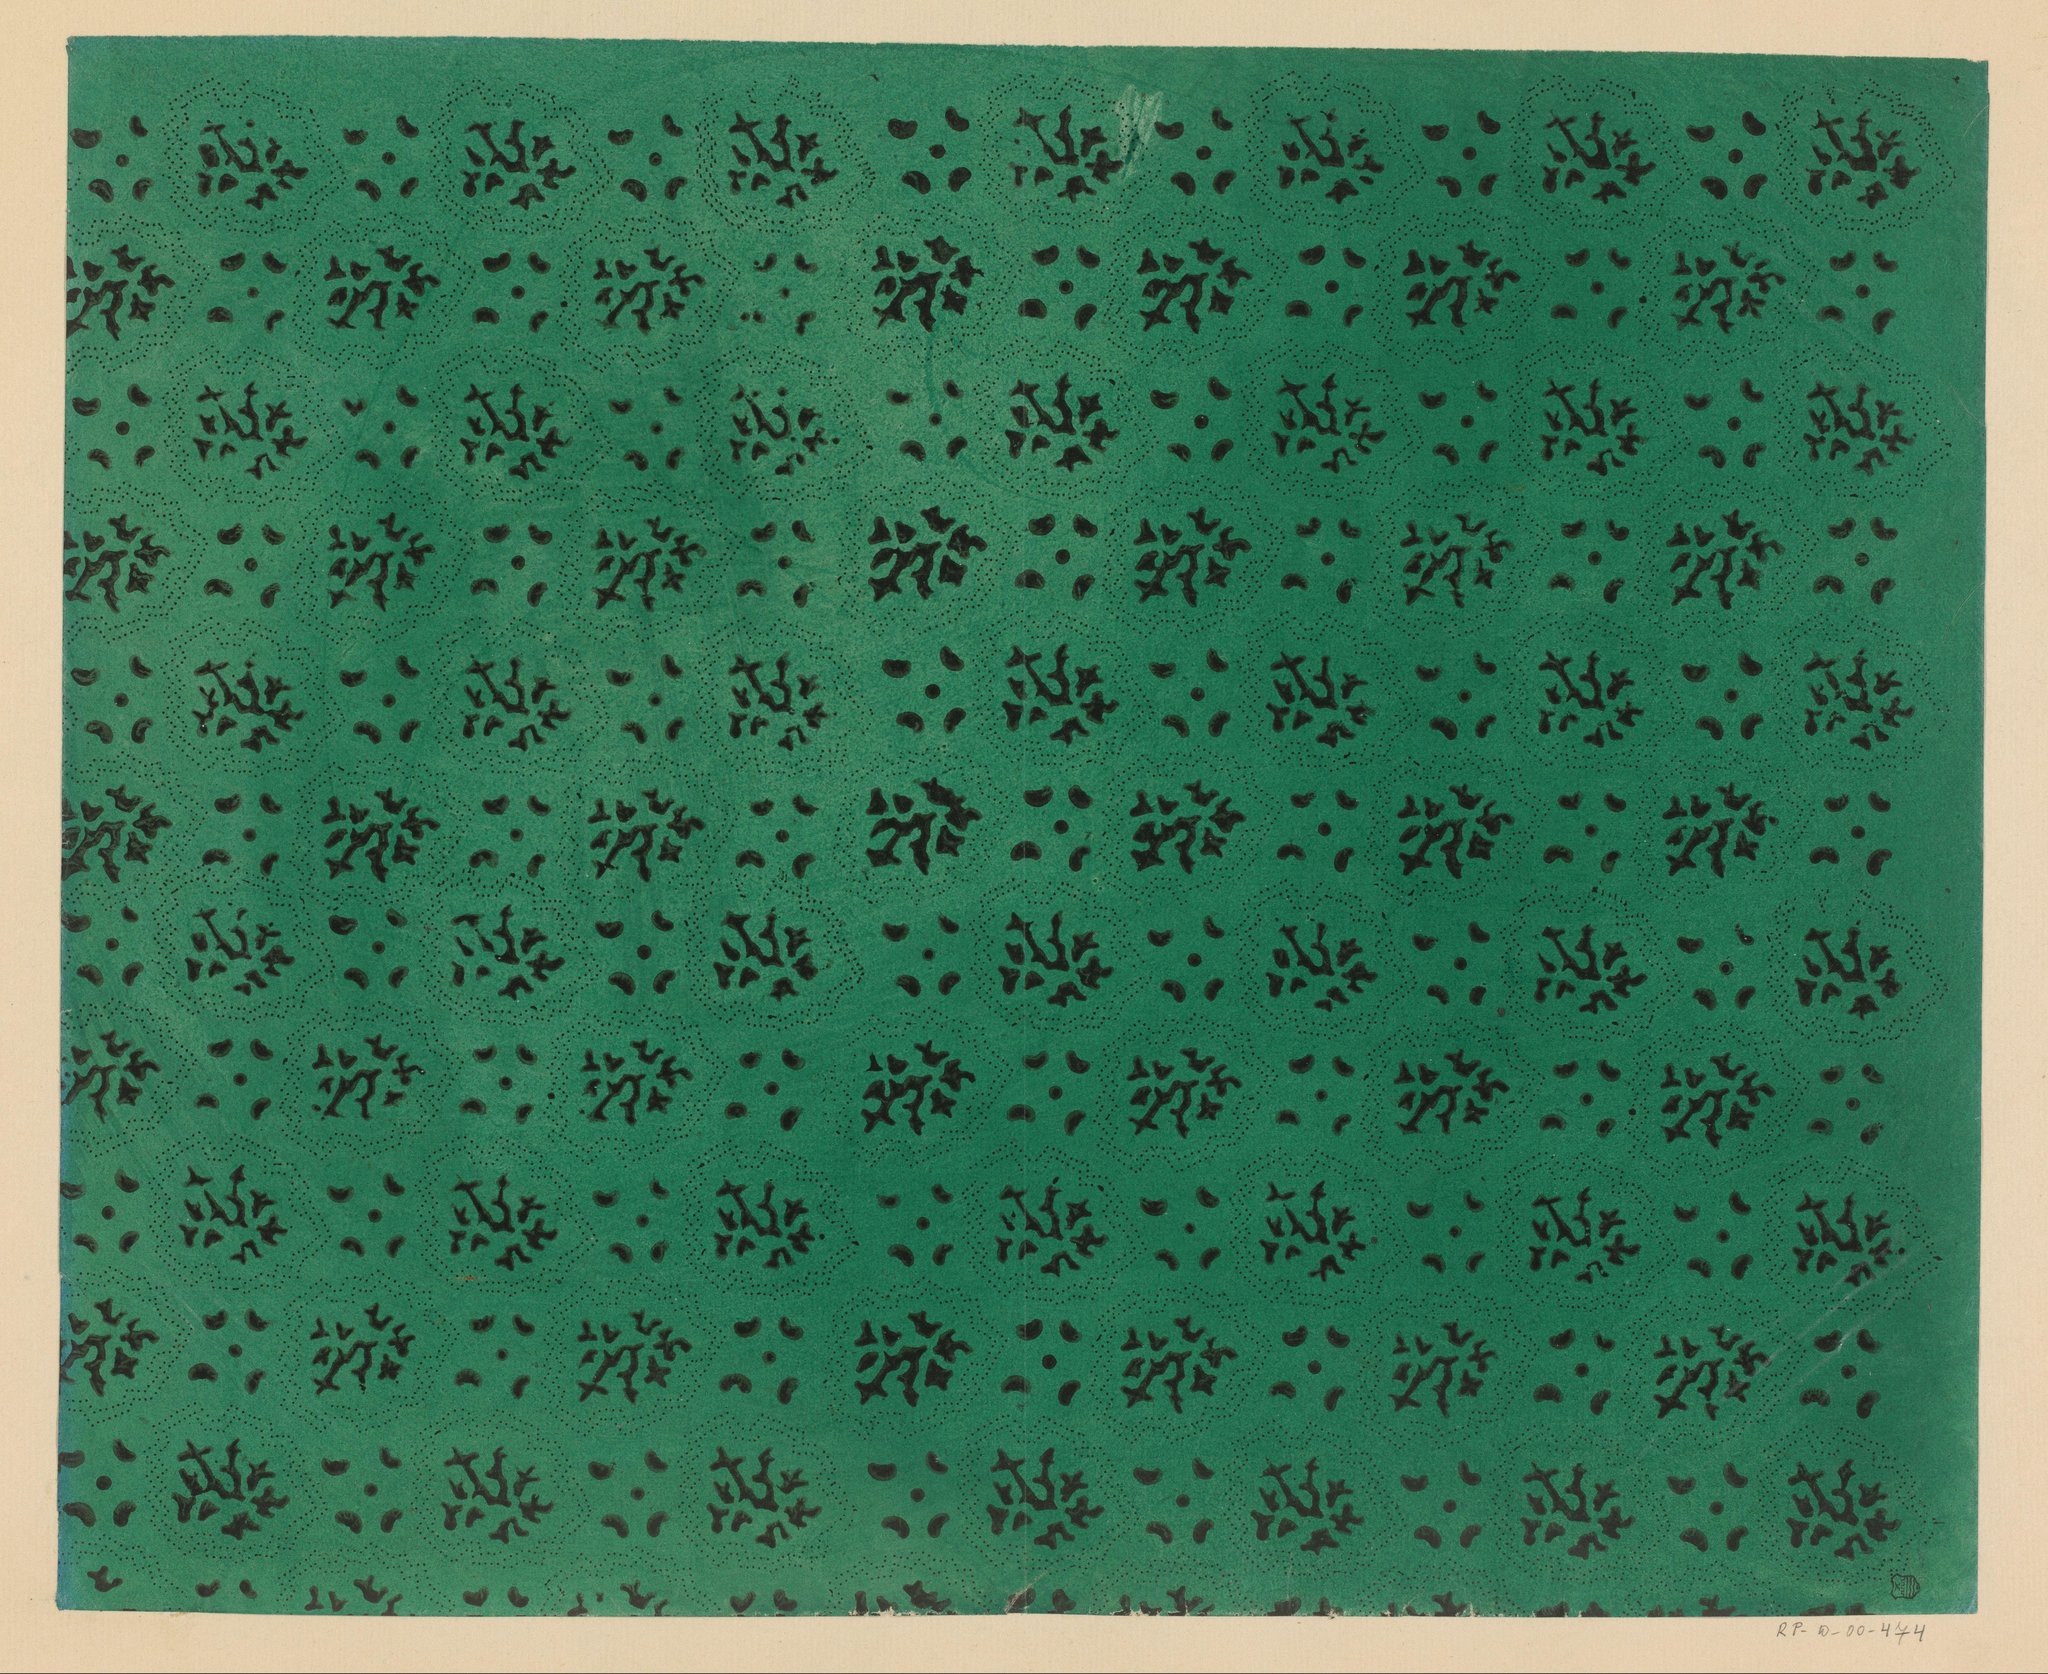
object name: printed paper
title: Blad met strooipatroon van motief omgeven door kronkelende lijnen bestaande uit punten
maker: Anonymous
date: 1800-1900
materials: paint, paper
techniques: printing block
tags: fantasy ornament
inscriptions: collector's mark: Lugt 2760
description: Blad met strooipatroon van fantasiemotief omgeven door kronkelende lijnen bestaande uit punten.